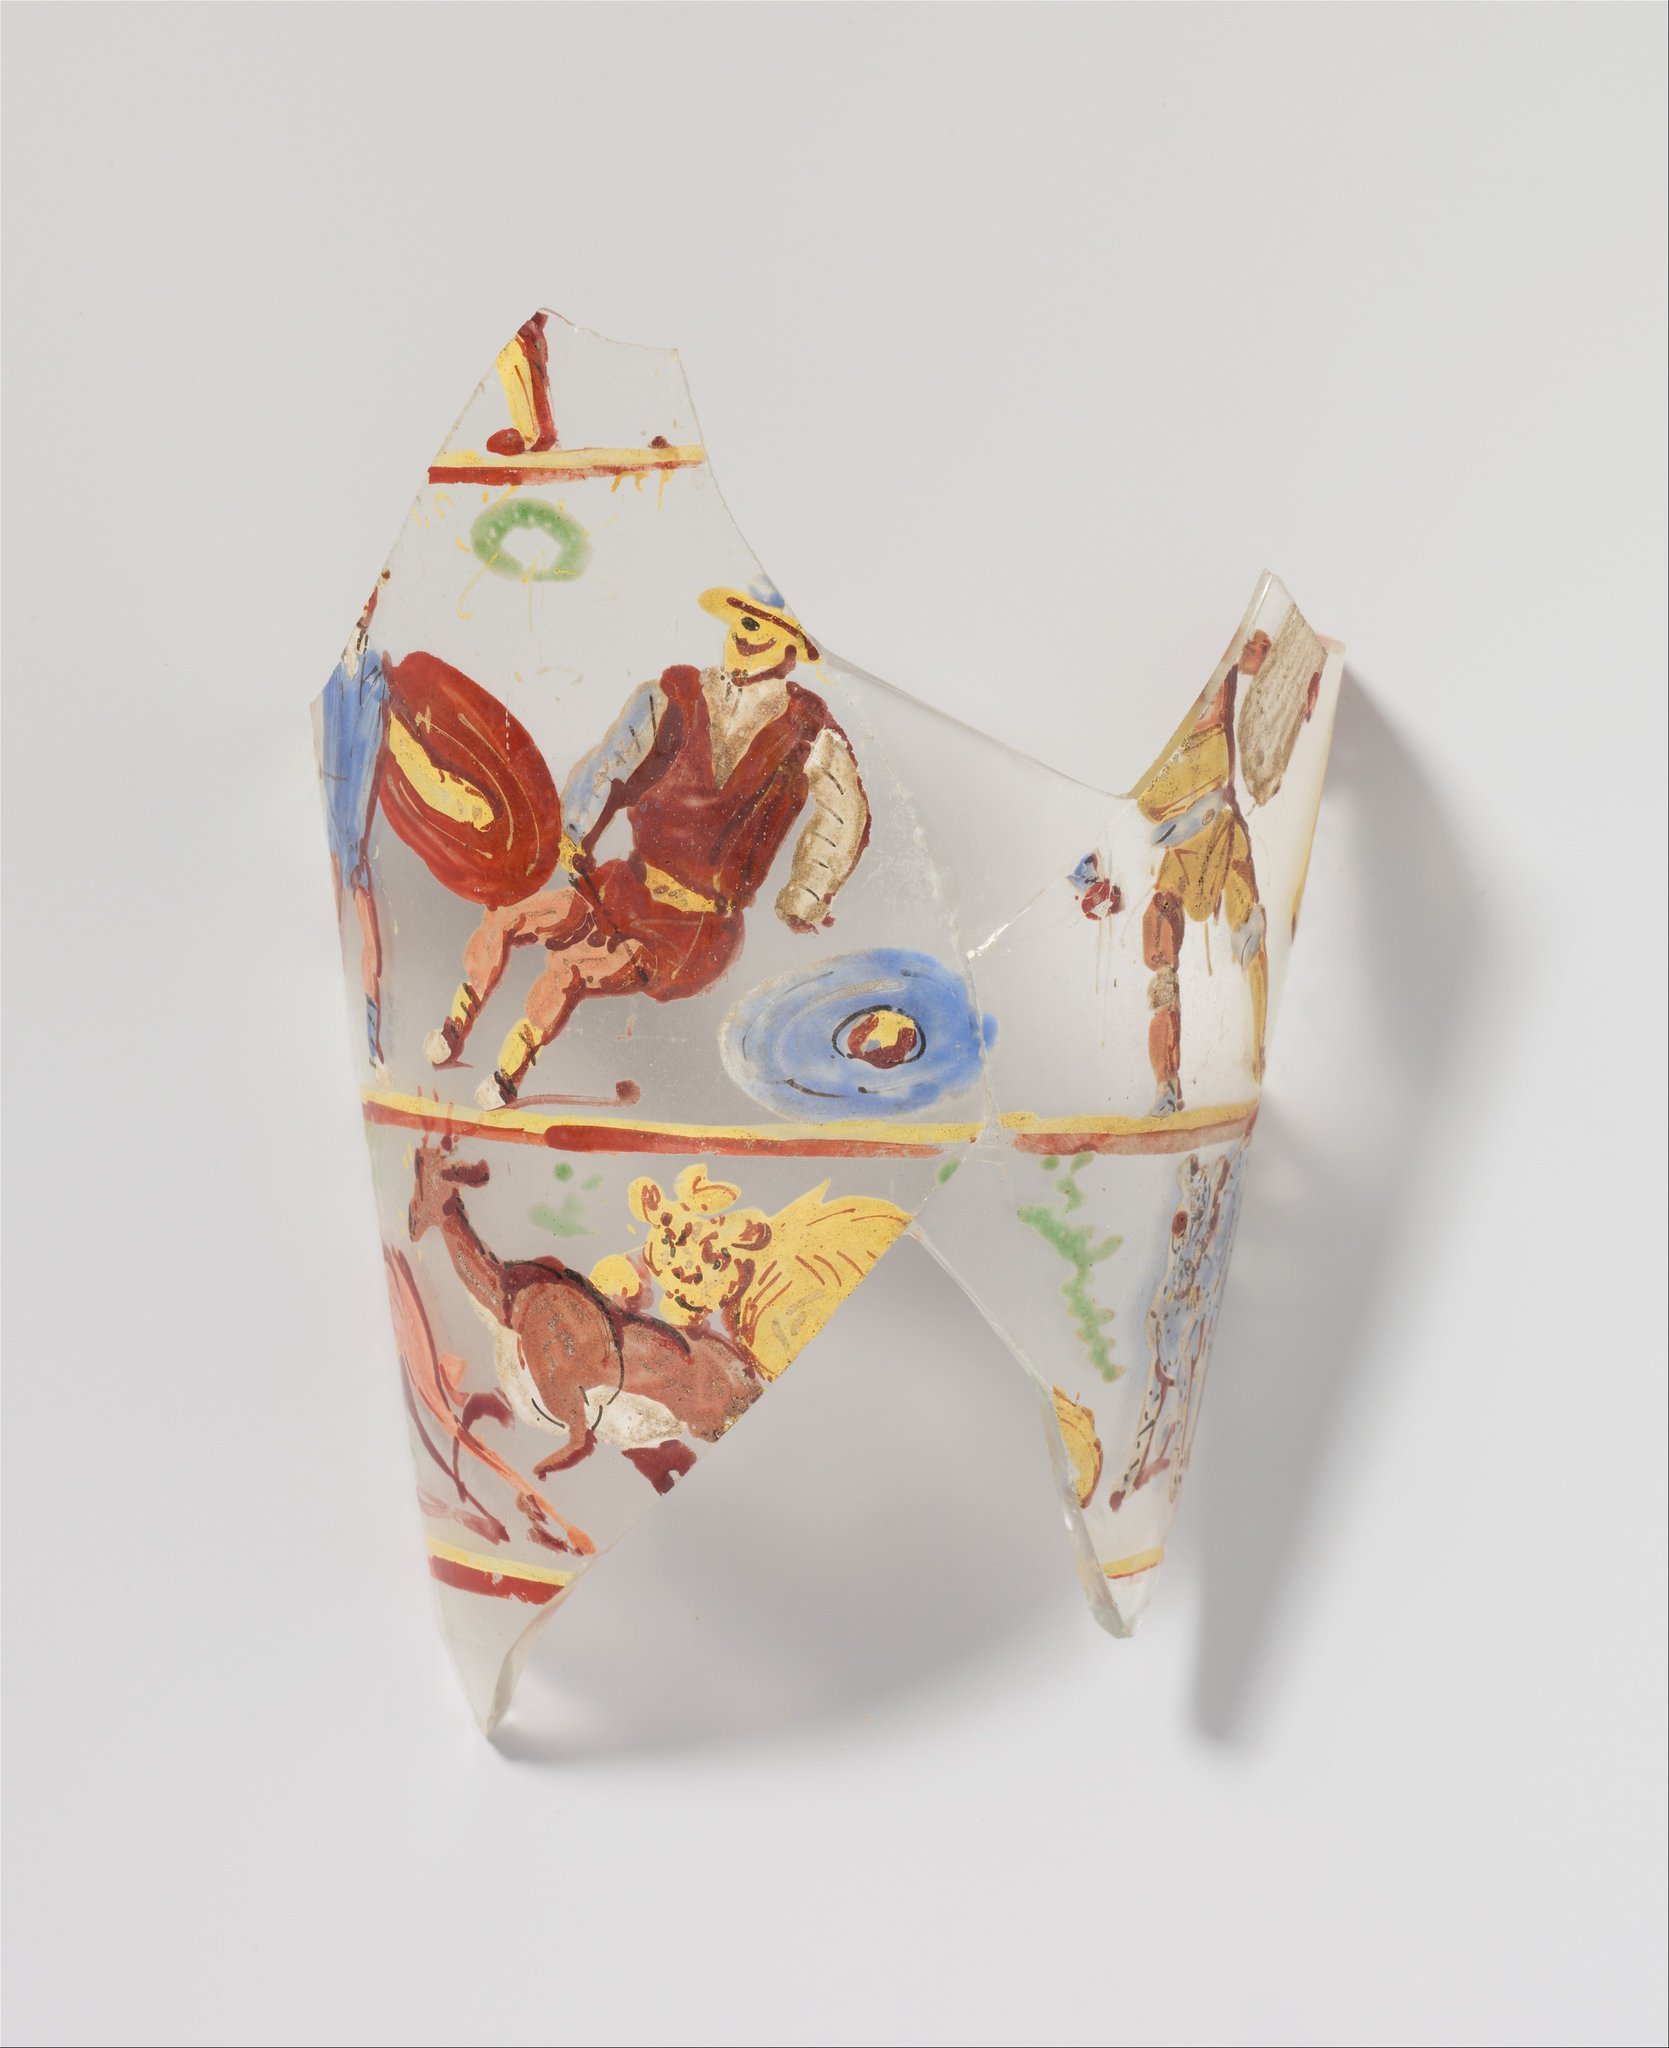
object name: beaker, fragmentary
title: Glass fragmentary beaker with painted decoration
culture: roman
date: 101-200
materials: glass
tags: men,deer,lions